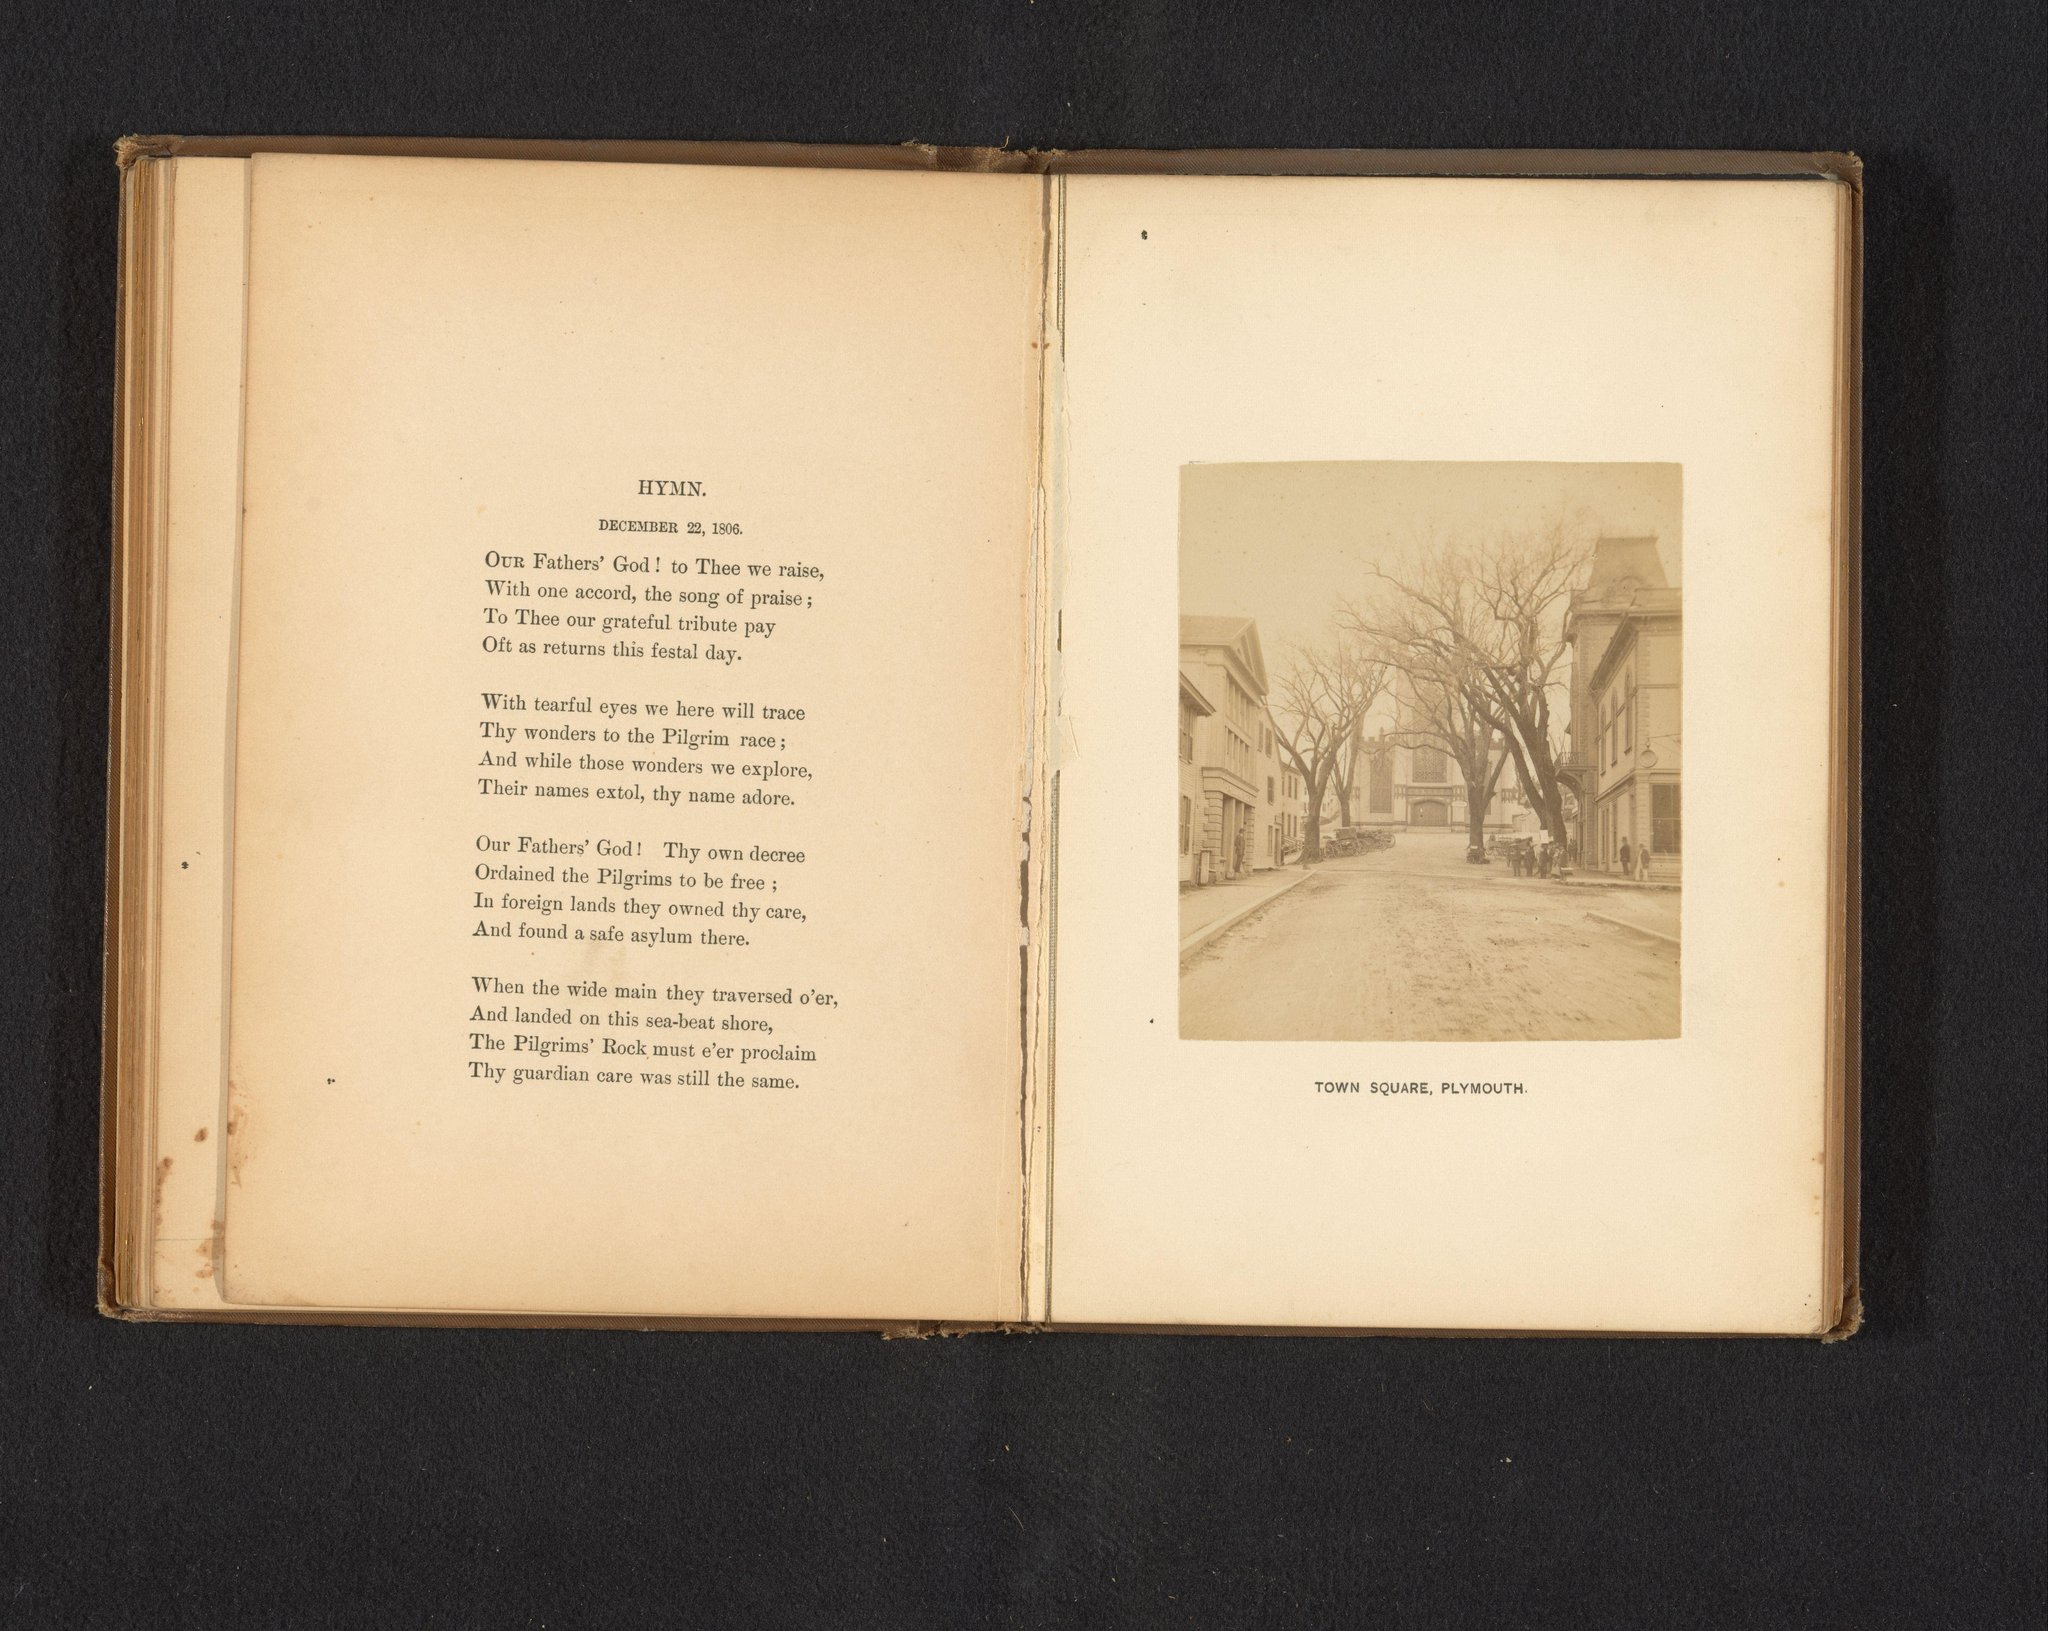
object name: photograph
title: Town square, Plymouth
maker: Anonymous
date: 1881-1886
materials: photographic support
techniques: albumen print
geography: plymouth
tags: village square, place, plymouth